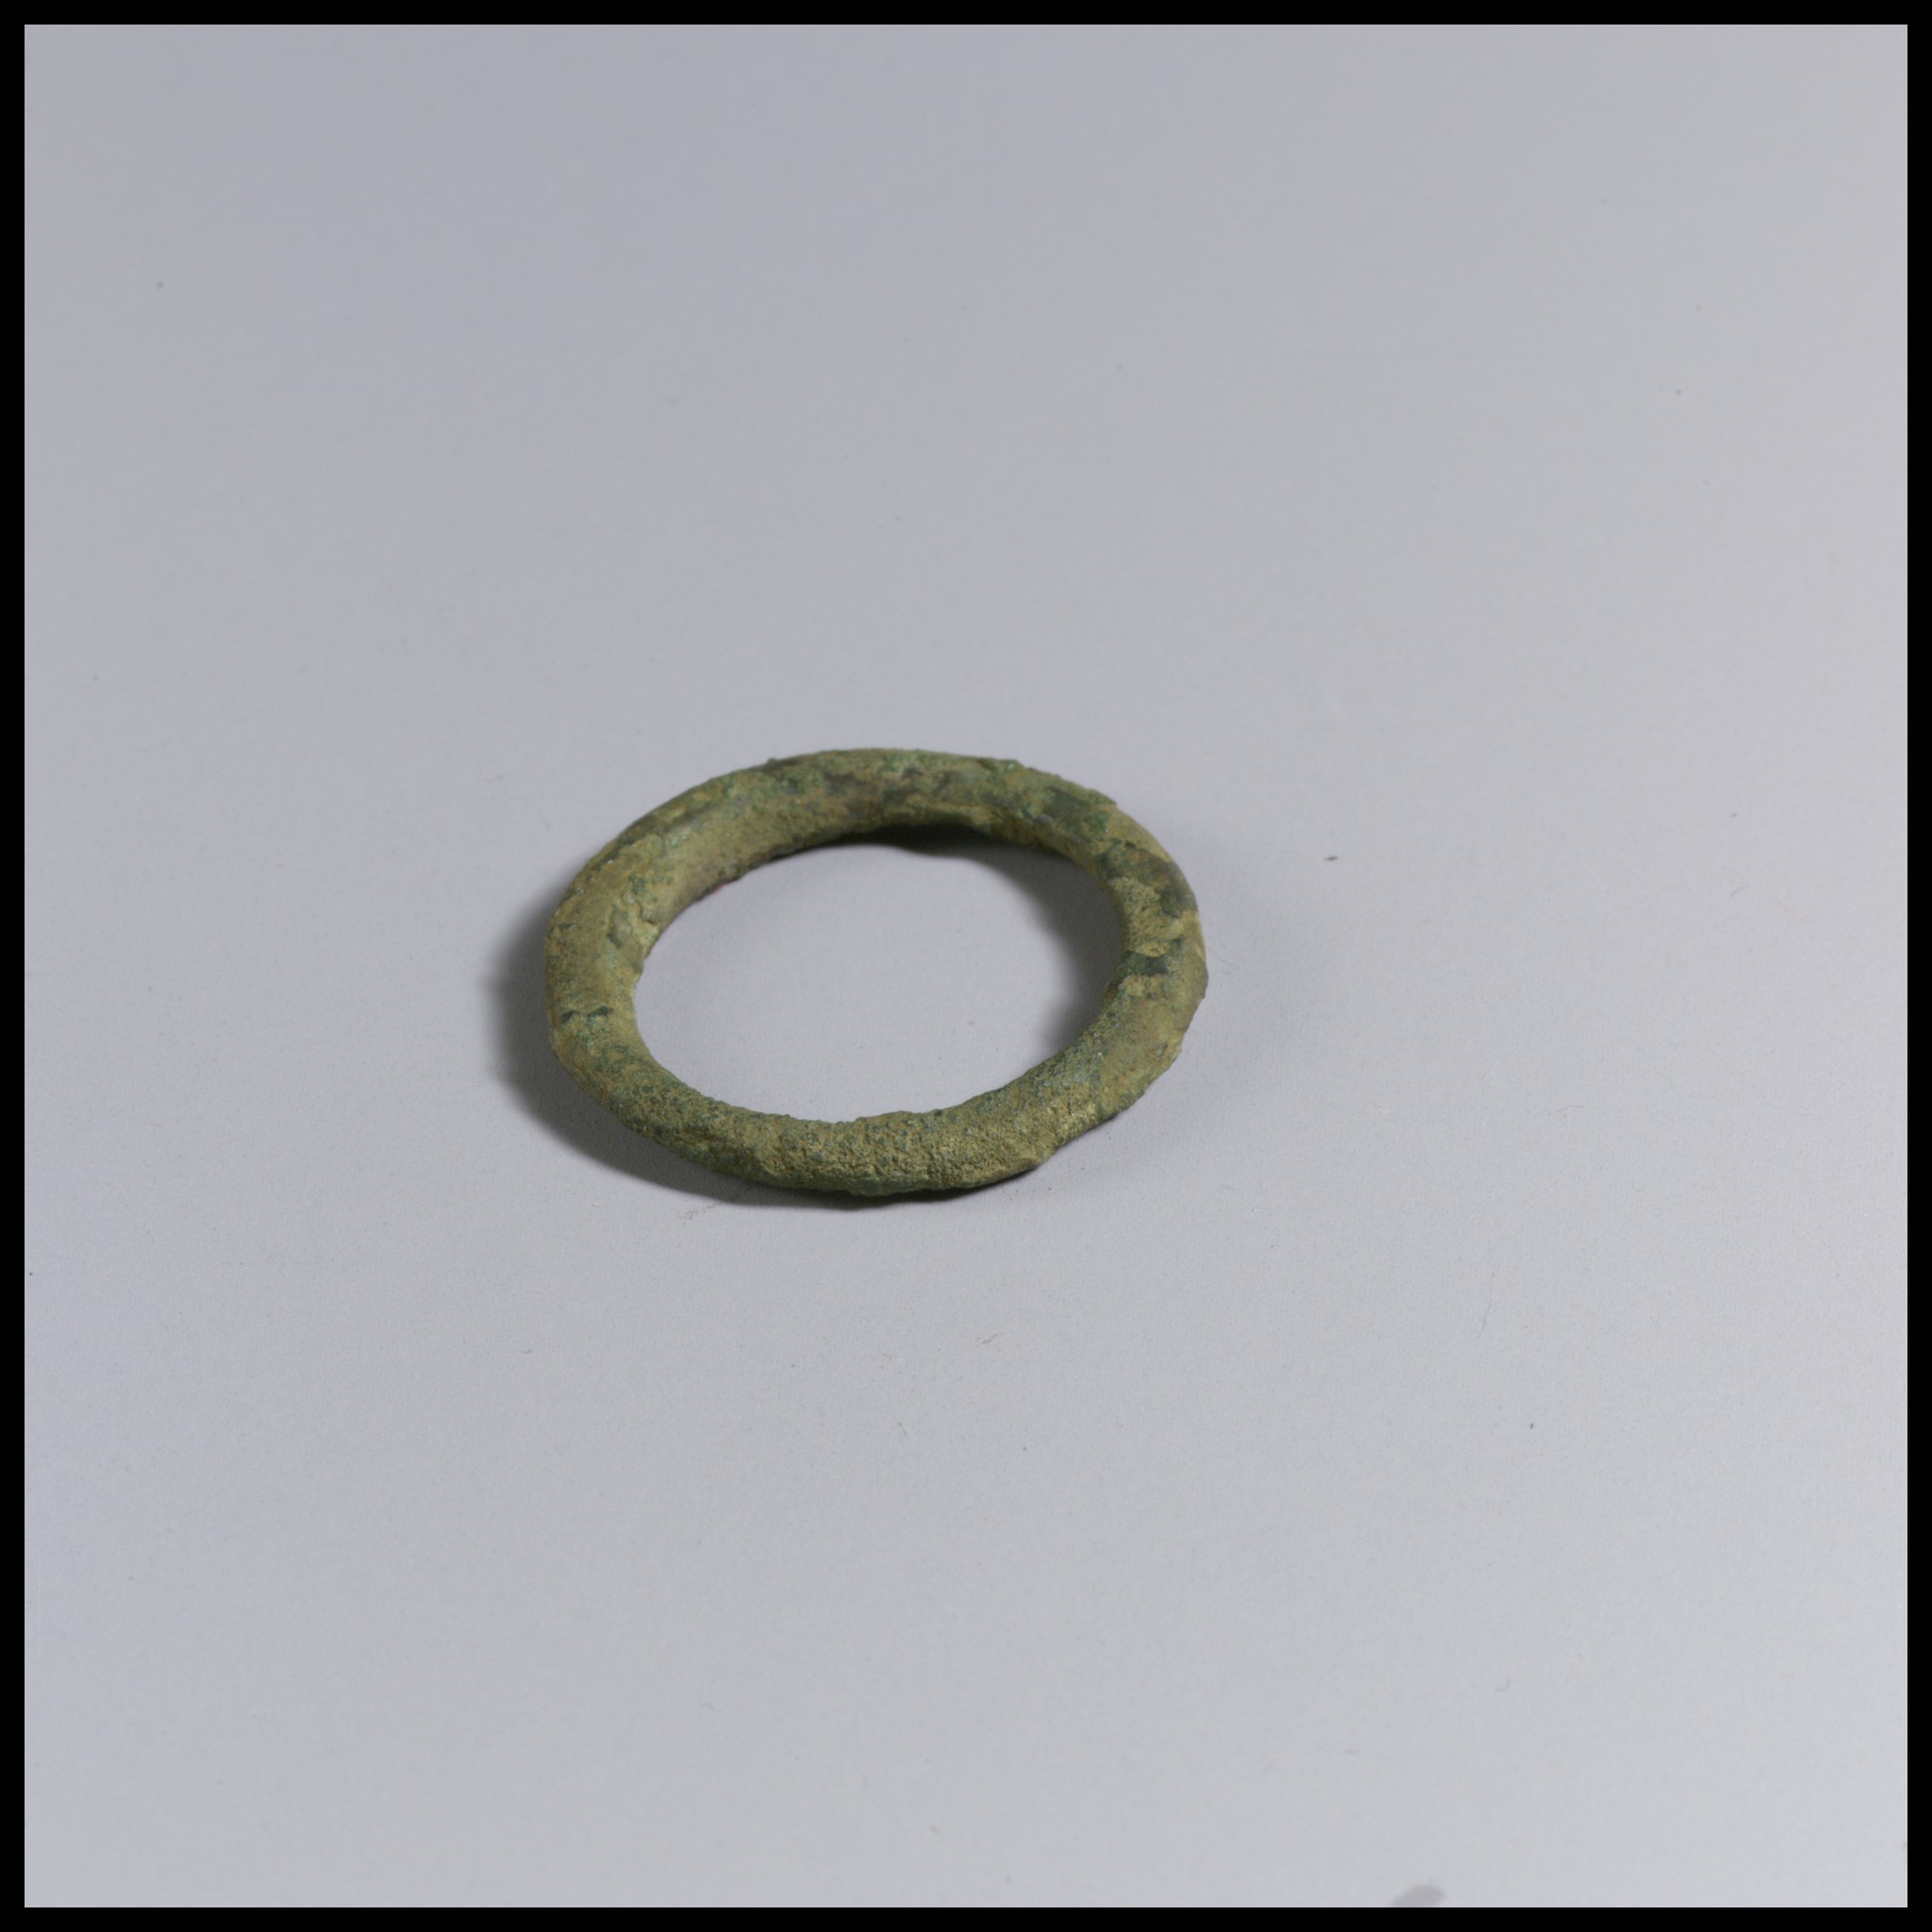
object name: ring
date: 7000 BCE-330 CE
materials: bronze